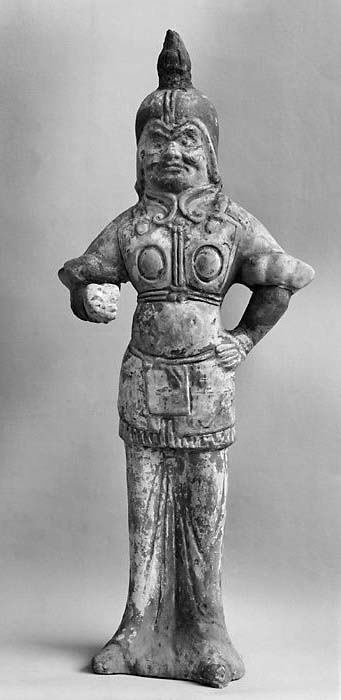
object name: figure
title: Warrior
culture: chinese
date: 601-800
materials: earthenware, pigment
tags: men